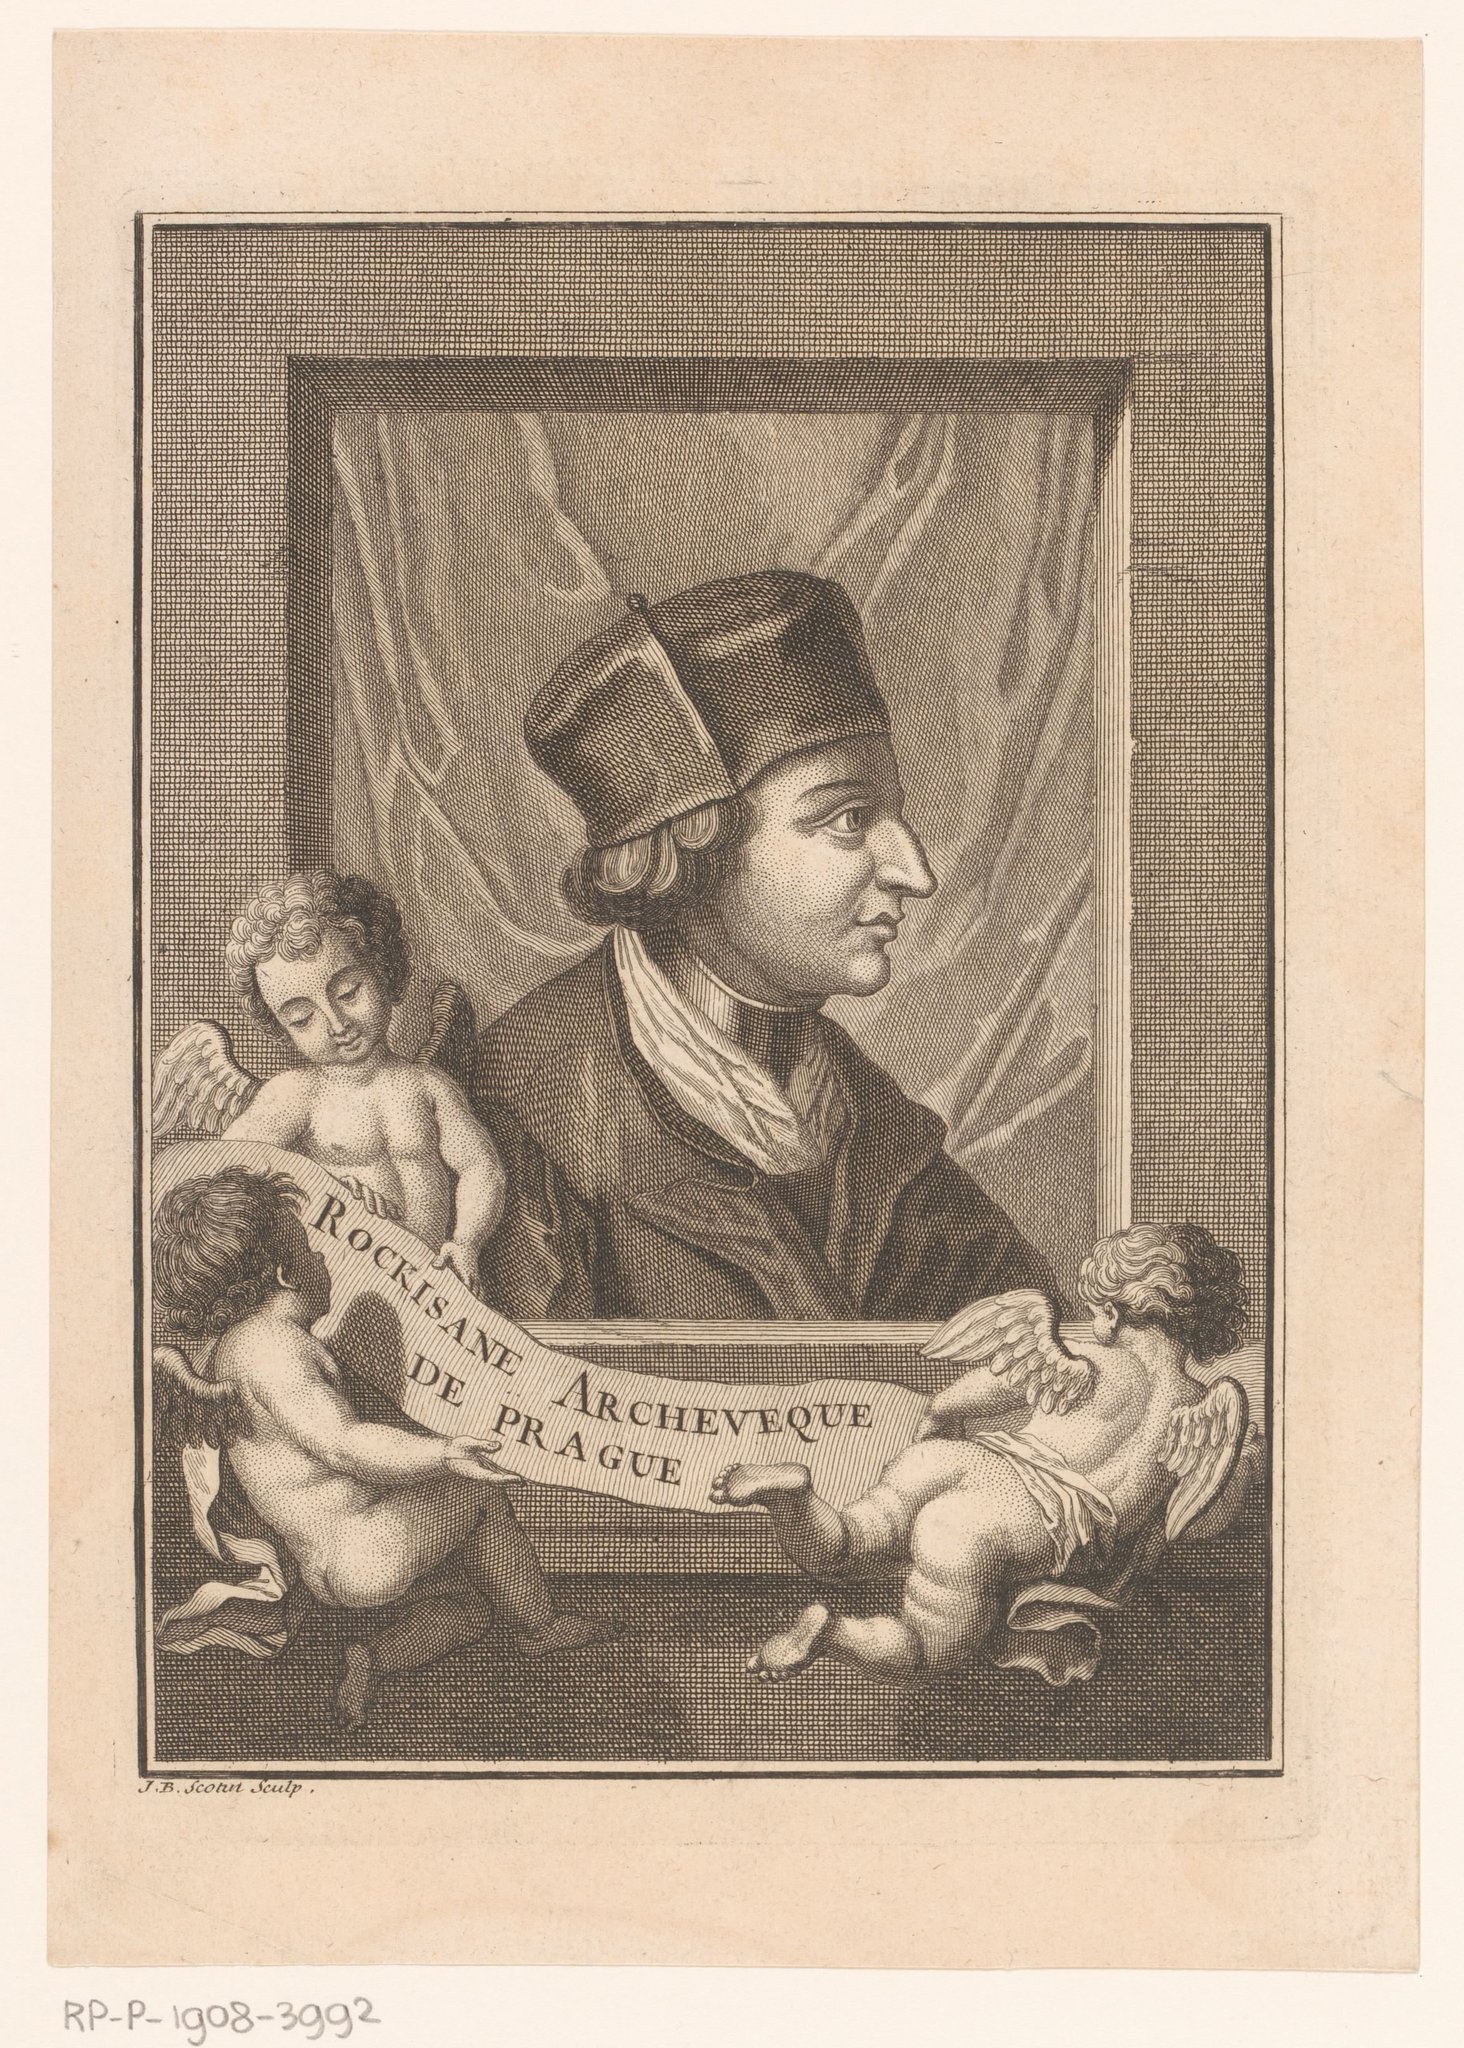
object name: print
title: Portret van Jean de Rockisanne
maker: jean baptiste scotin (i)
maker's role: print maker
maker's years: 1678-1740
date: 1688-1733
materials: paper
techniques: engraving, etching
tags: archbishop, bishop, etc. (roman catholic), historical persons, cupids: 'amores', 'amoretti', 'putti'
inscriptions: collector's mark: Lugt 2228